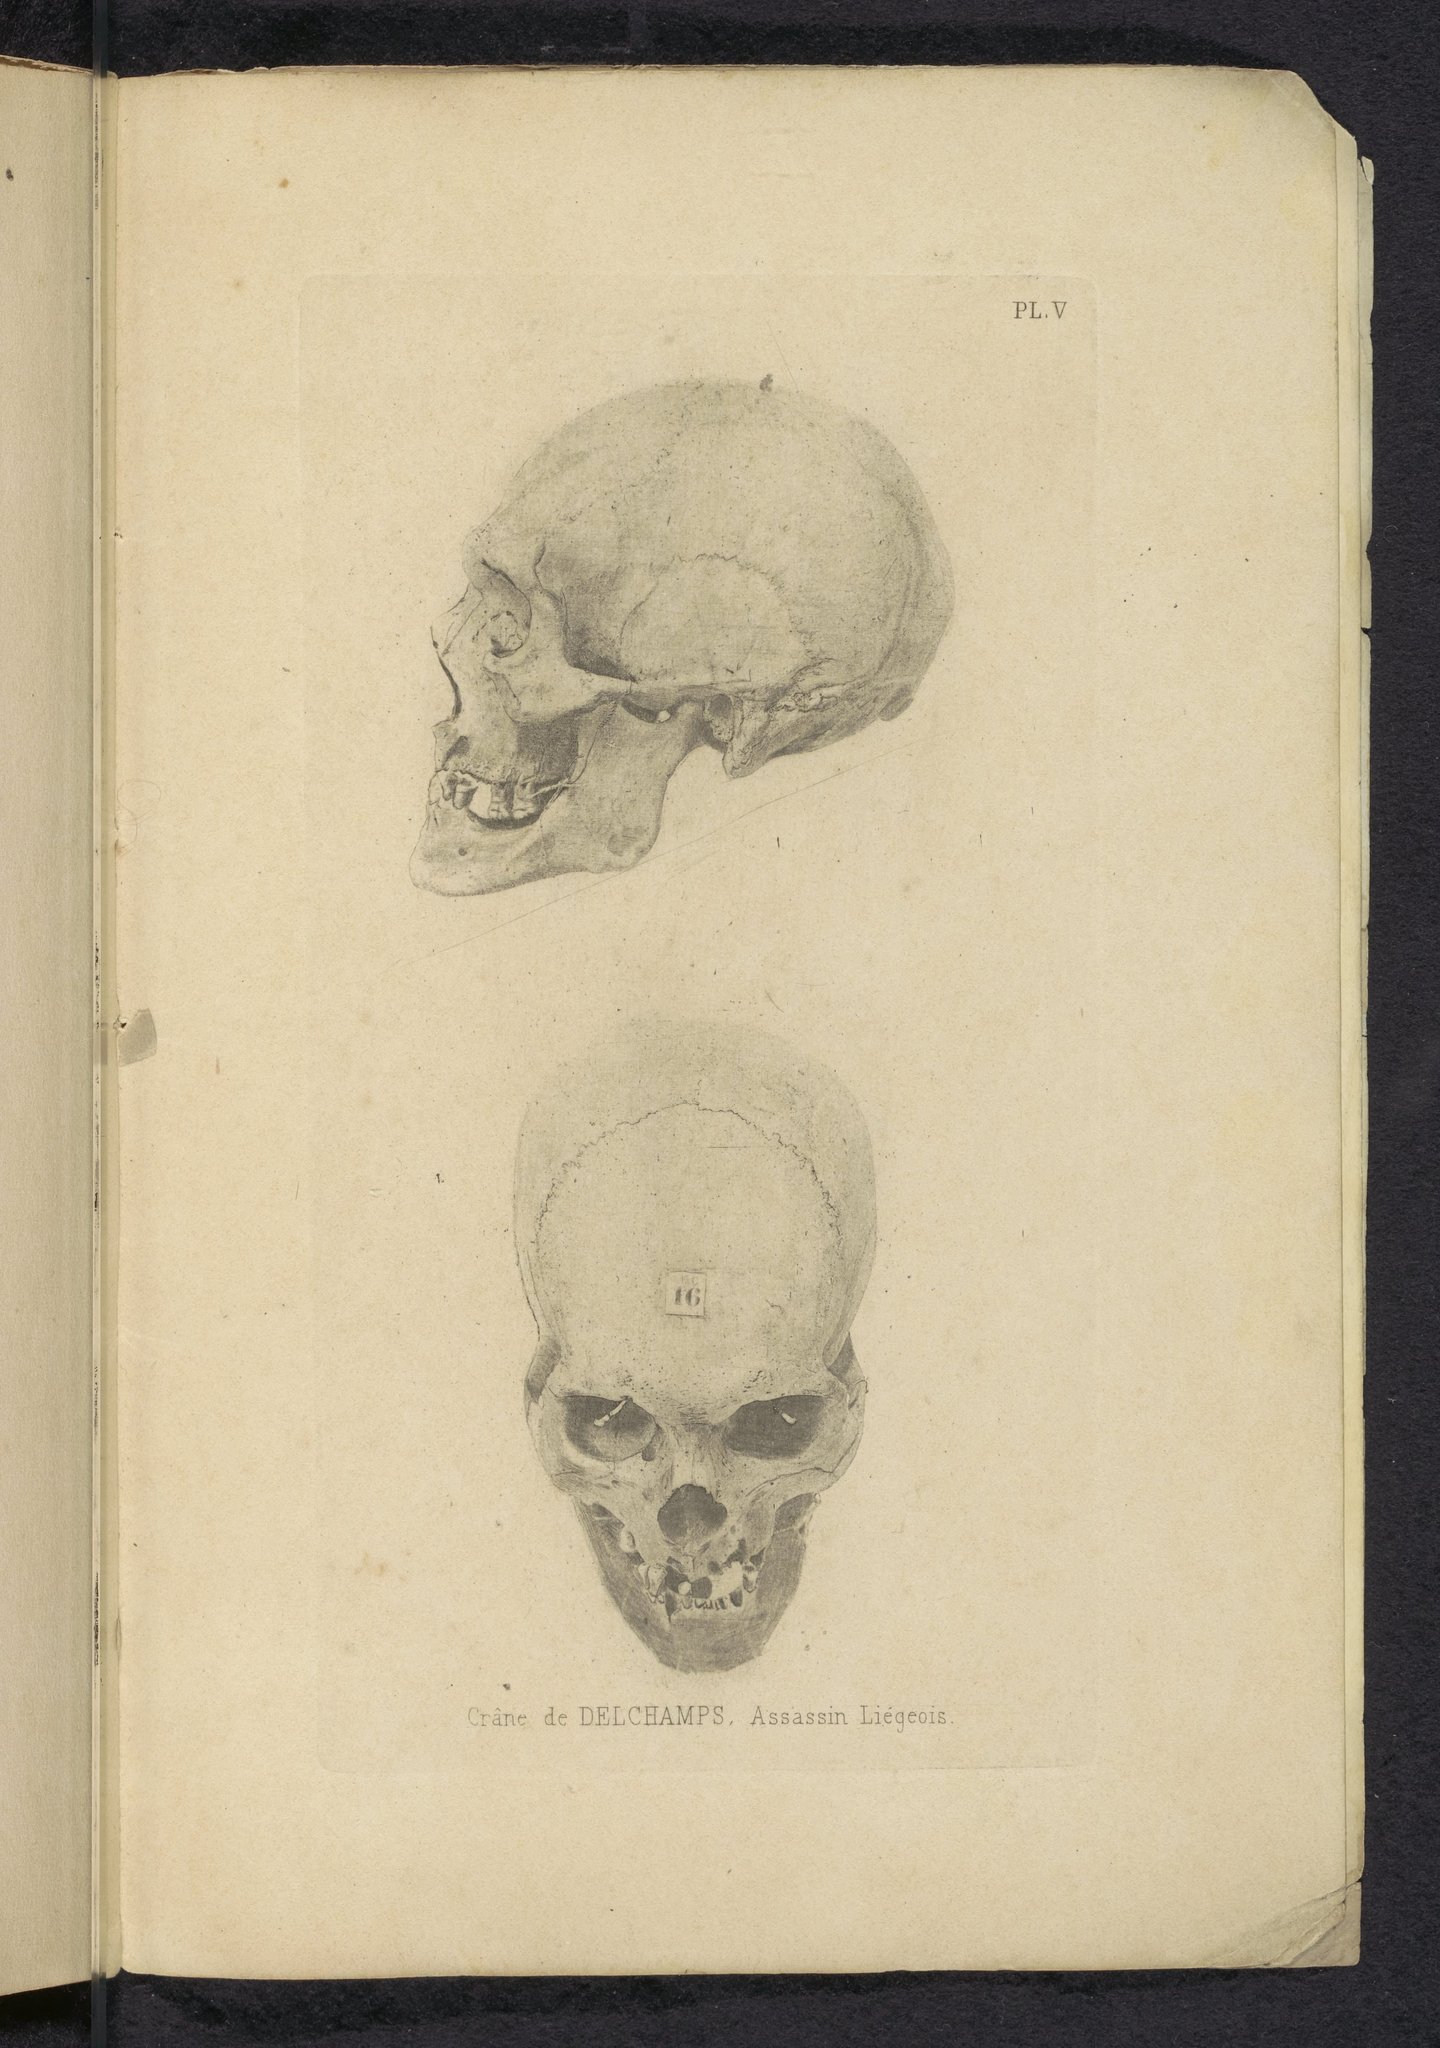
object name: photomechanical print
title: Twee aanzichten van een schedel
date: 1871-1881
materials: paper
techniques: photoaquatint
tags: (human) skull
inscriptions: number: ‘PL. V.’, inscription: ‘IC 16’